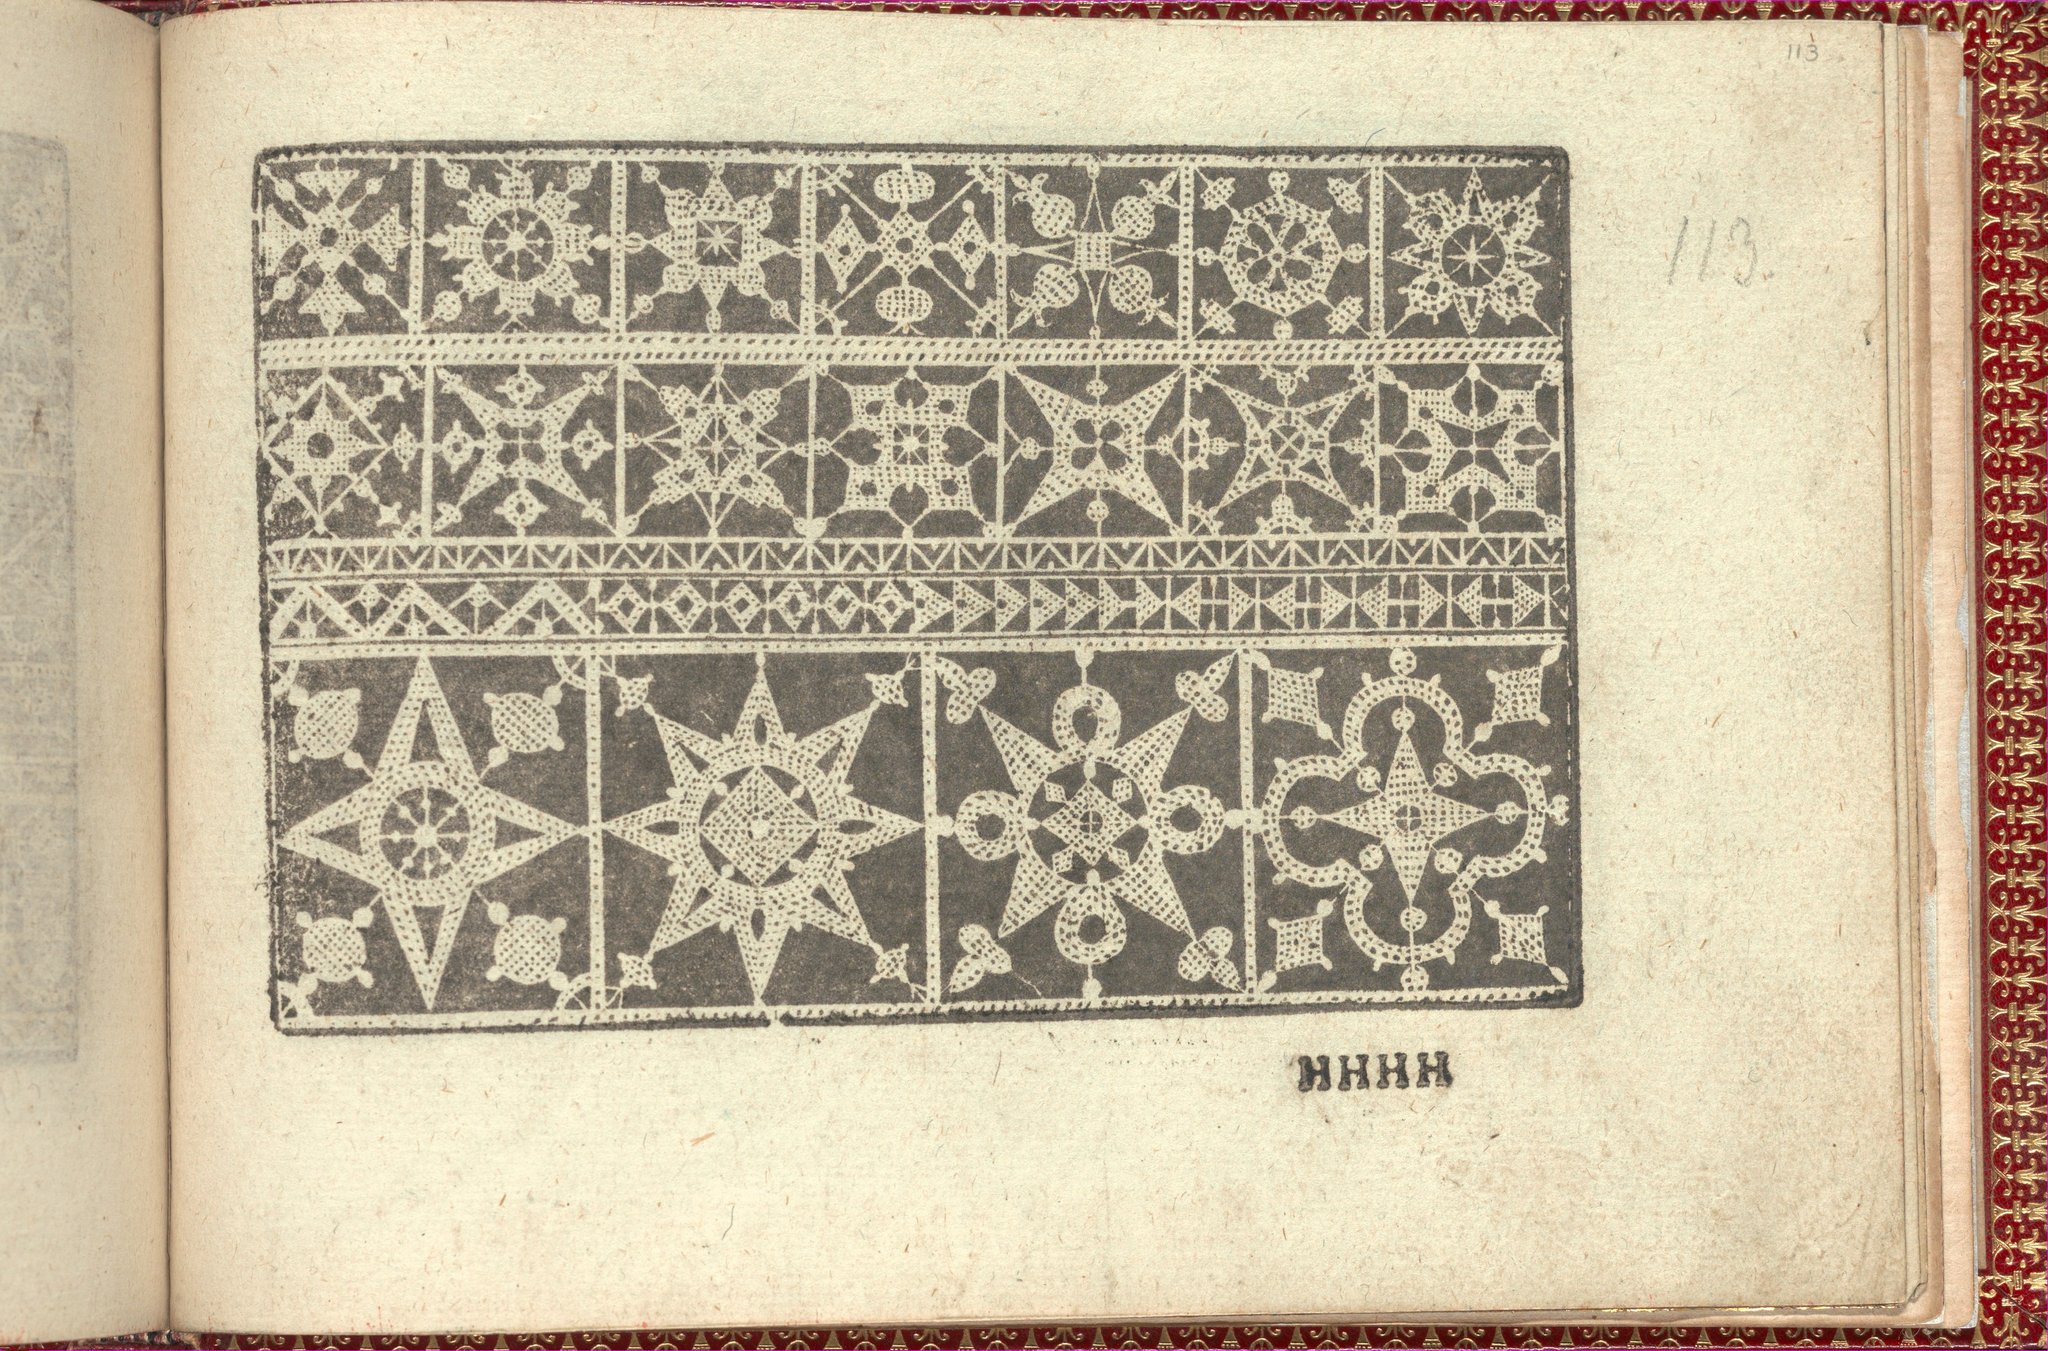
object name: book print ornament architecture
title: Corona delle Nobili et Virtuose Donne: Libro I-IV, page 113 (recto)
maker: cesare vecellio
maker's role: publisher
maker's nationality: italian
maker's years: 1521-1601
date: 1601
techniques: woodcut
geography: italy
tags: ornament